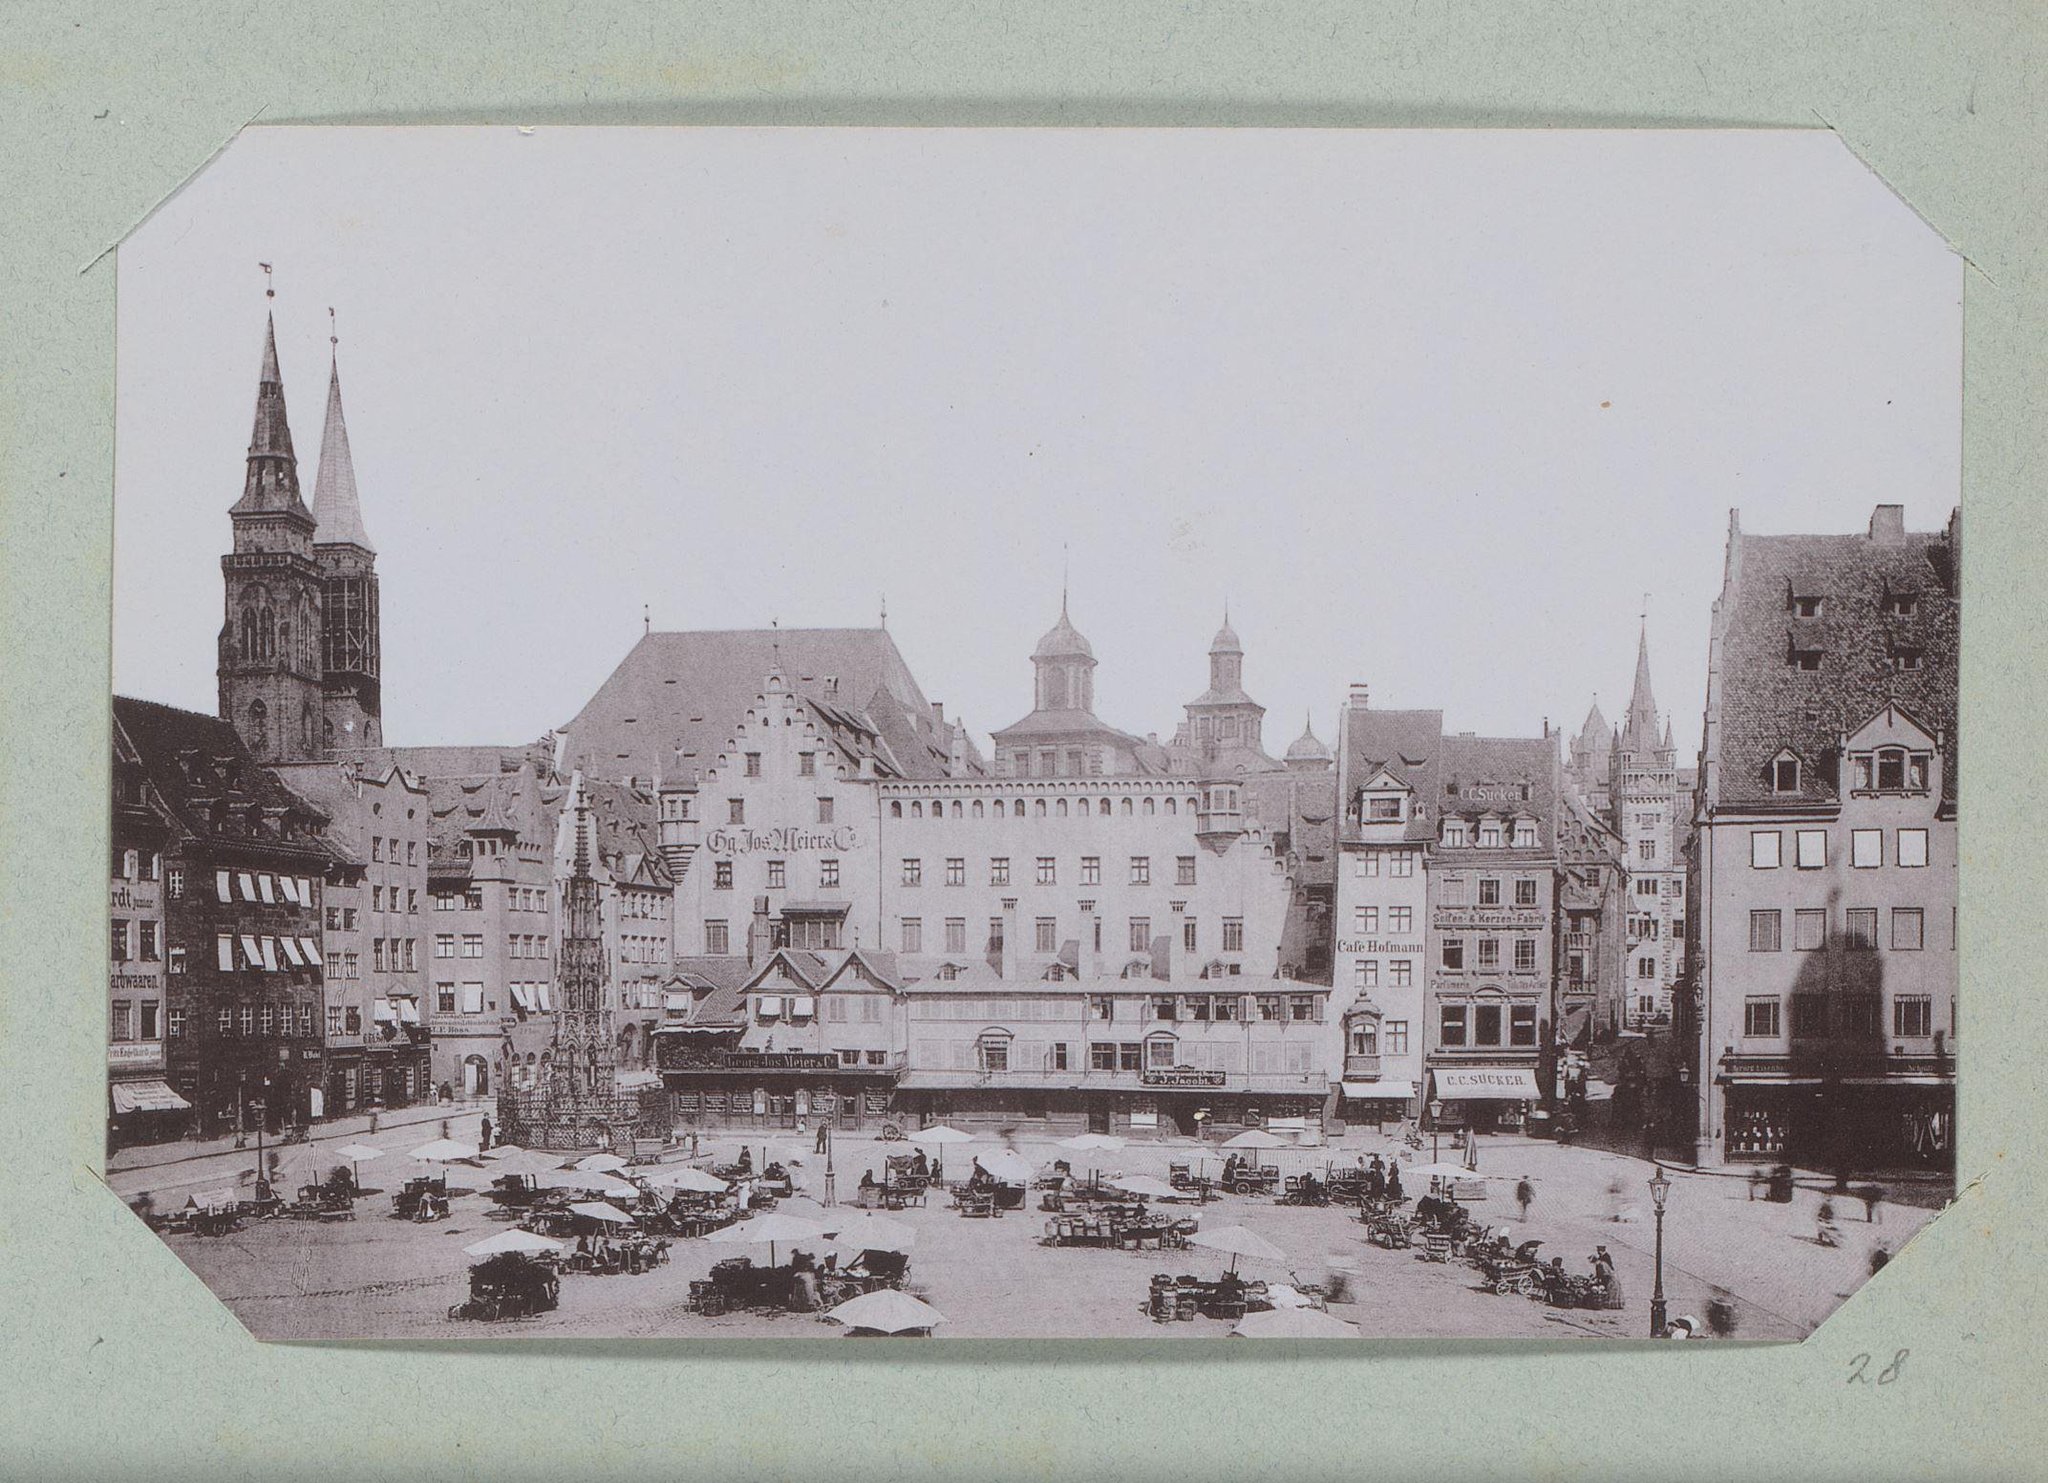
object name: album leaf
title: Gezicht op de Hauptmarkt, Neurenberg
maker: Anonymous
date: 1890-1900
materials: paper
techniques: photograph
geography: nuremberg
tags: square, place, circus, etc., urban housing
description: Deze prent maakt deel uit van een album.